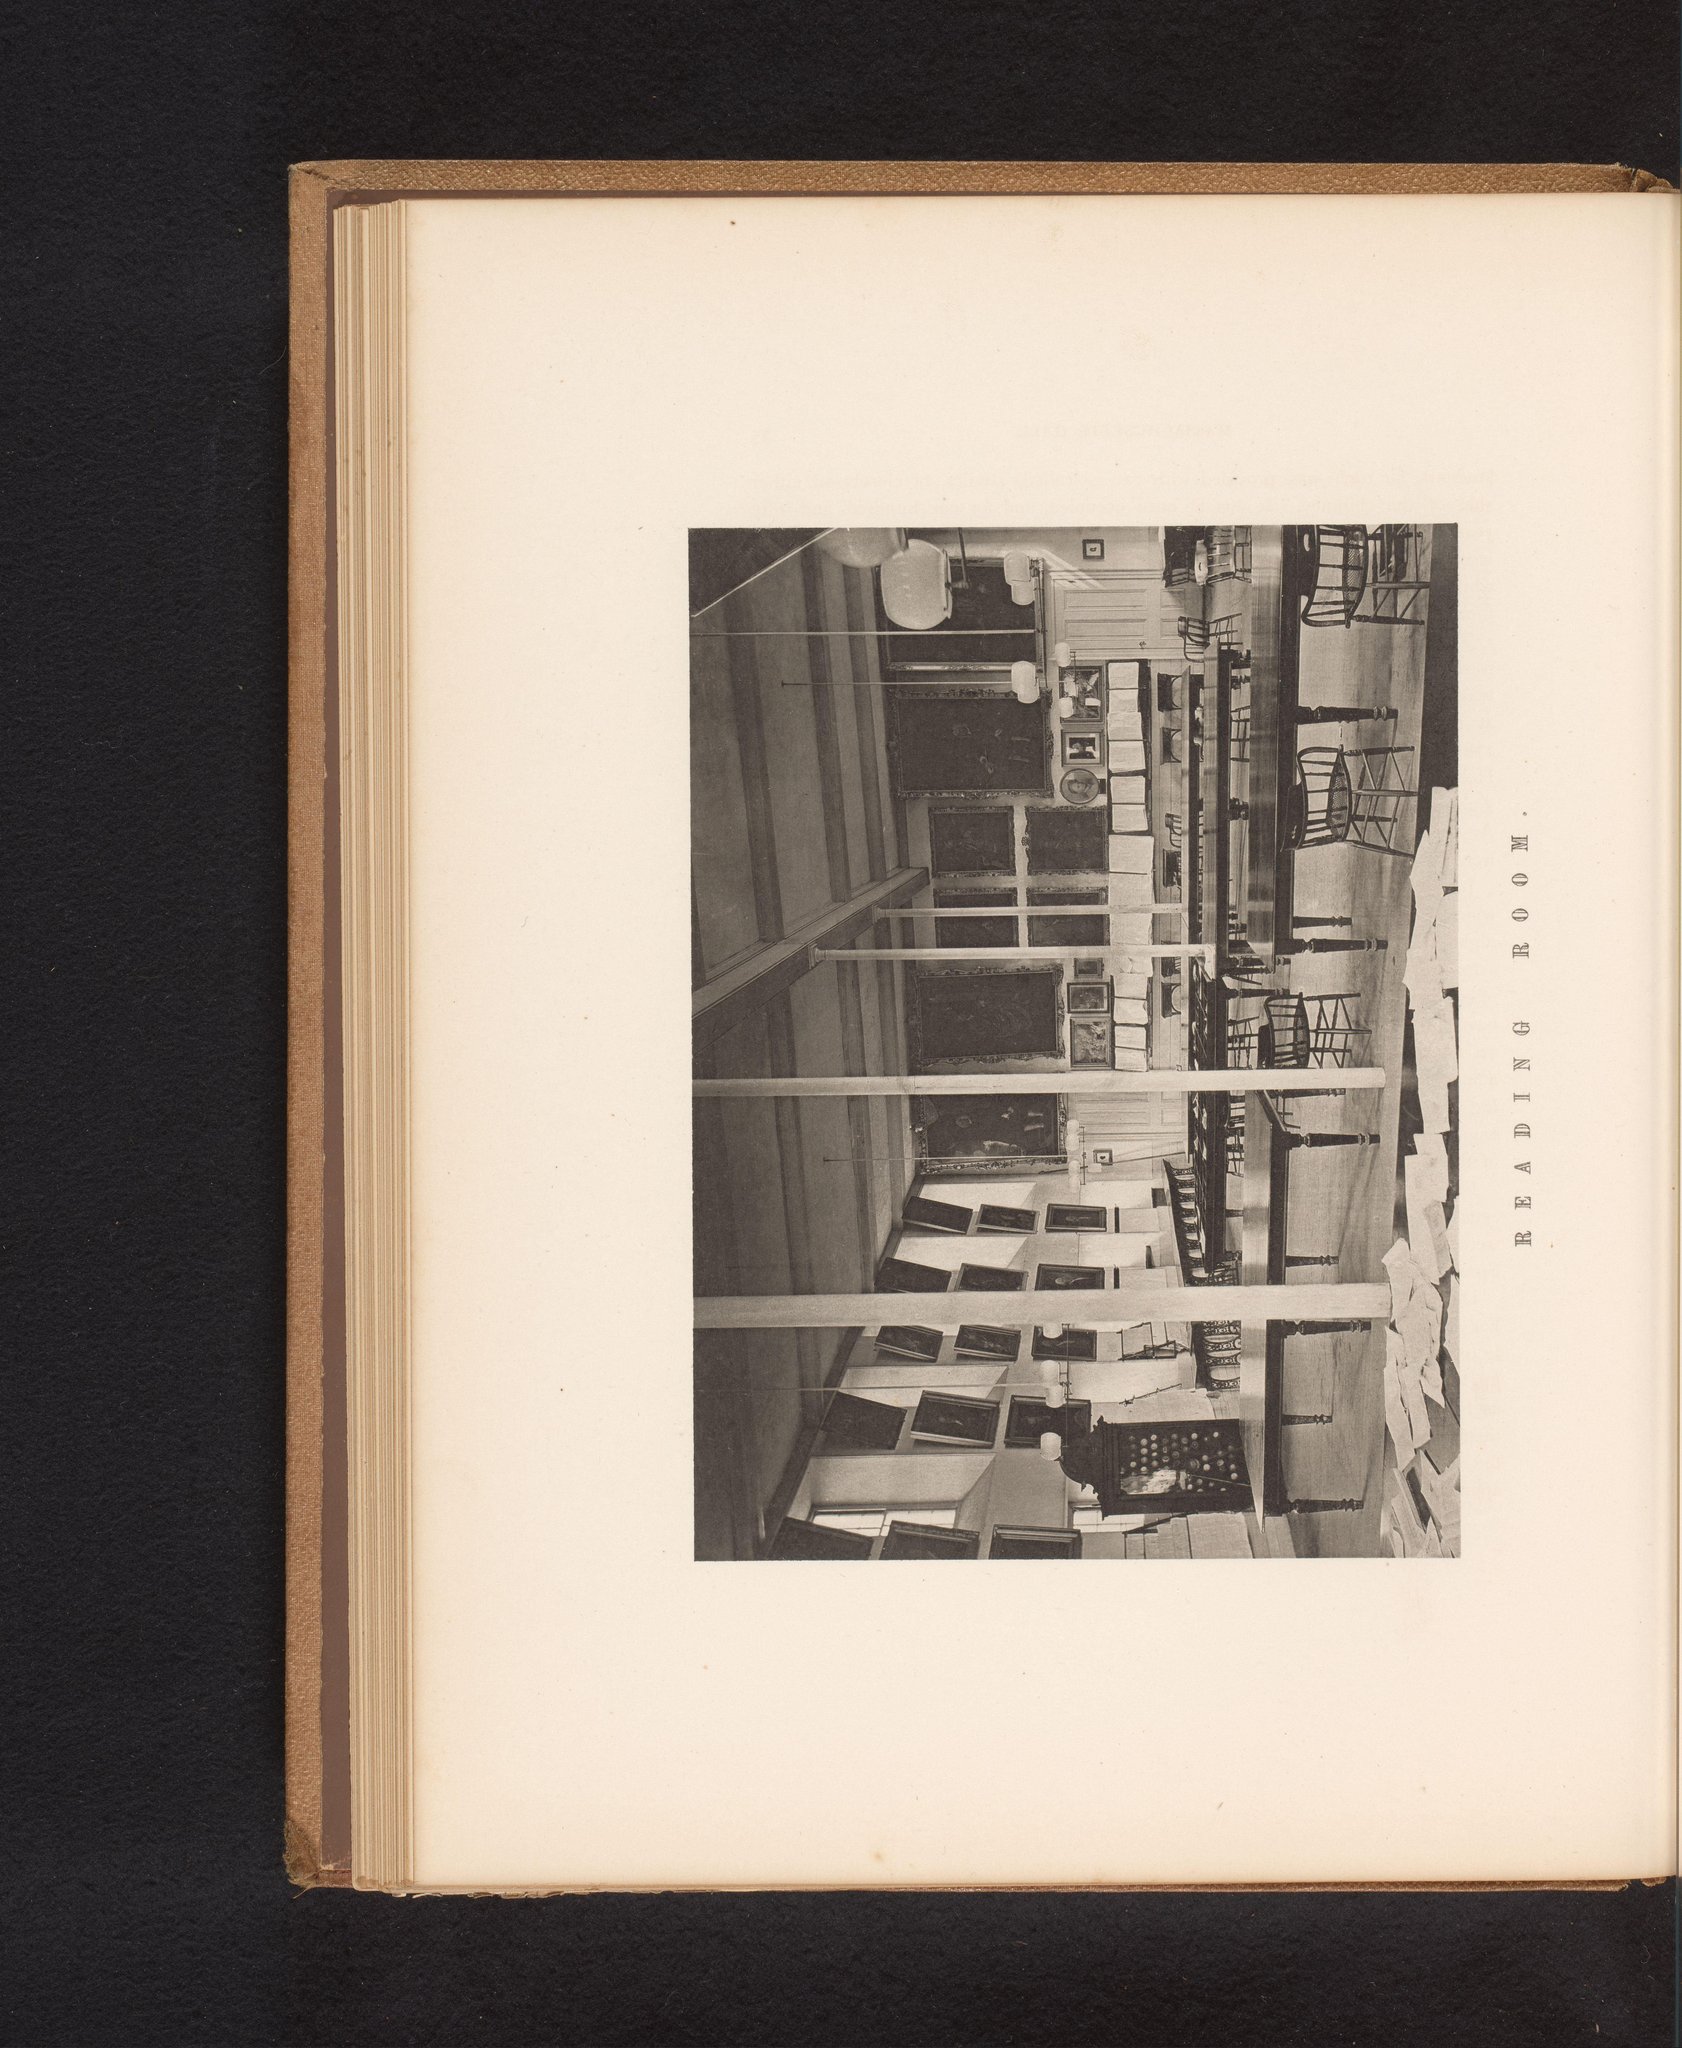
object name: page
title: Reading room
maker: Anonymous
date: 1870-1875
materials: paper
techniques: photograph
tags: writing-table, writing-desk, university (+ building ~ education, tuition)